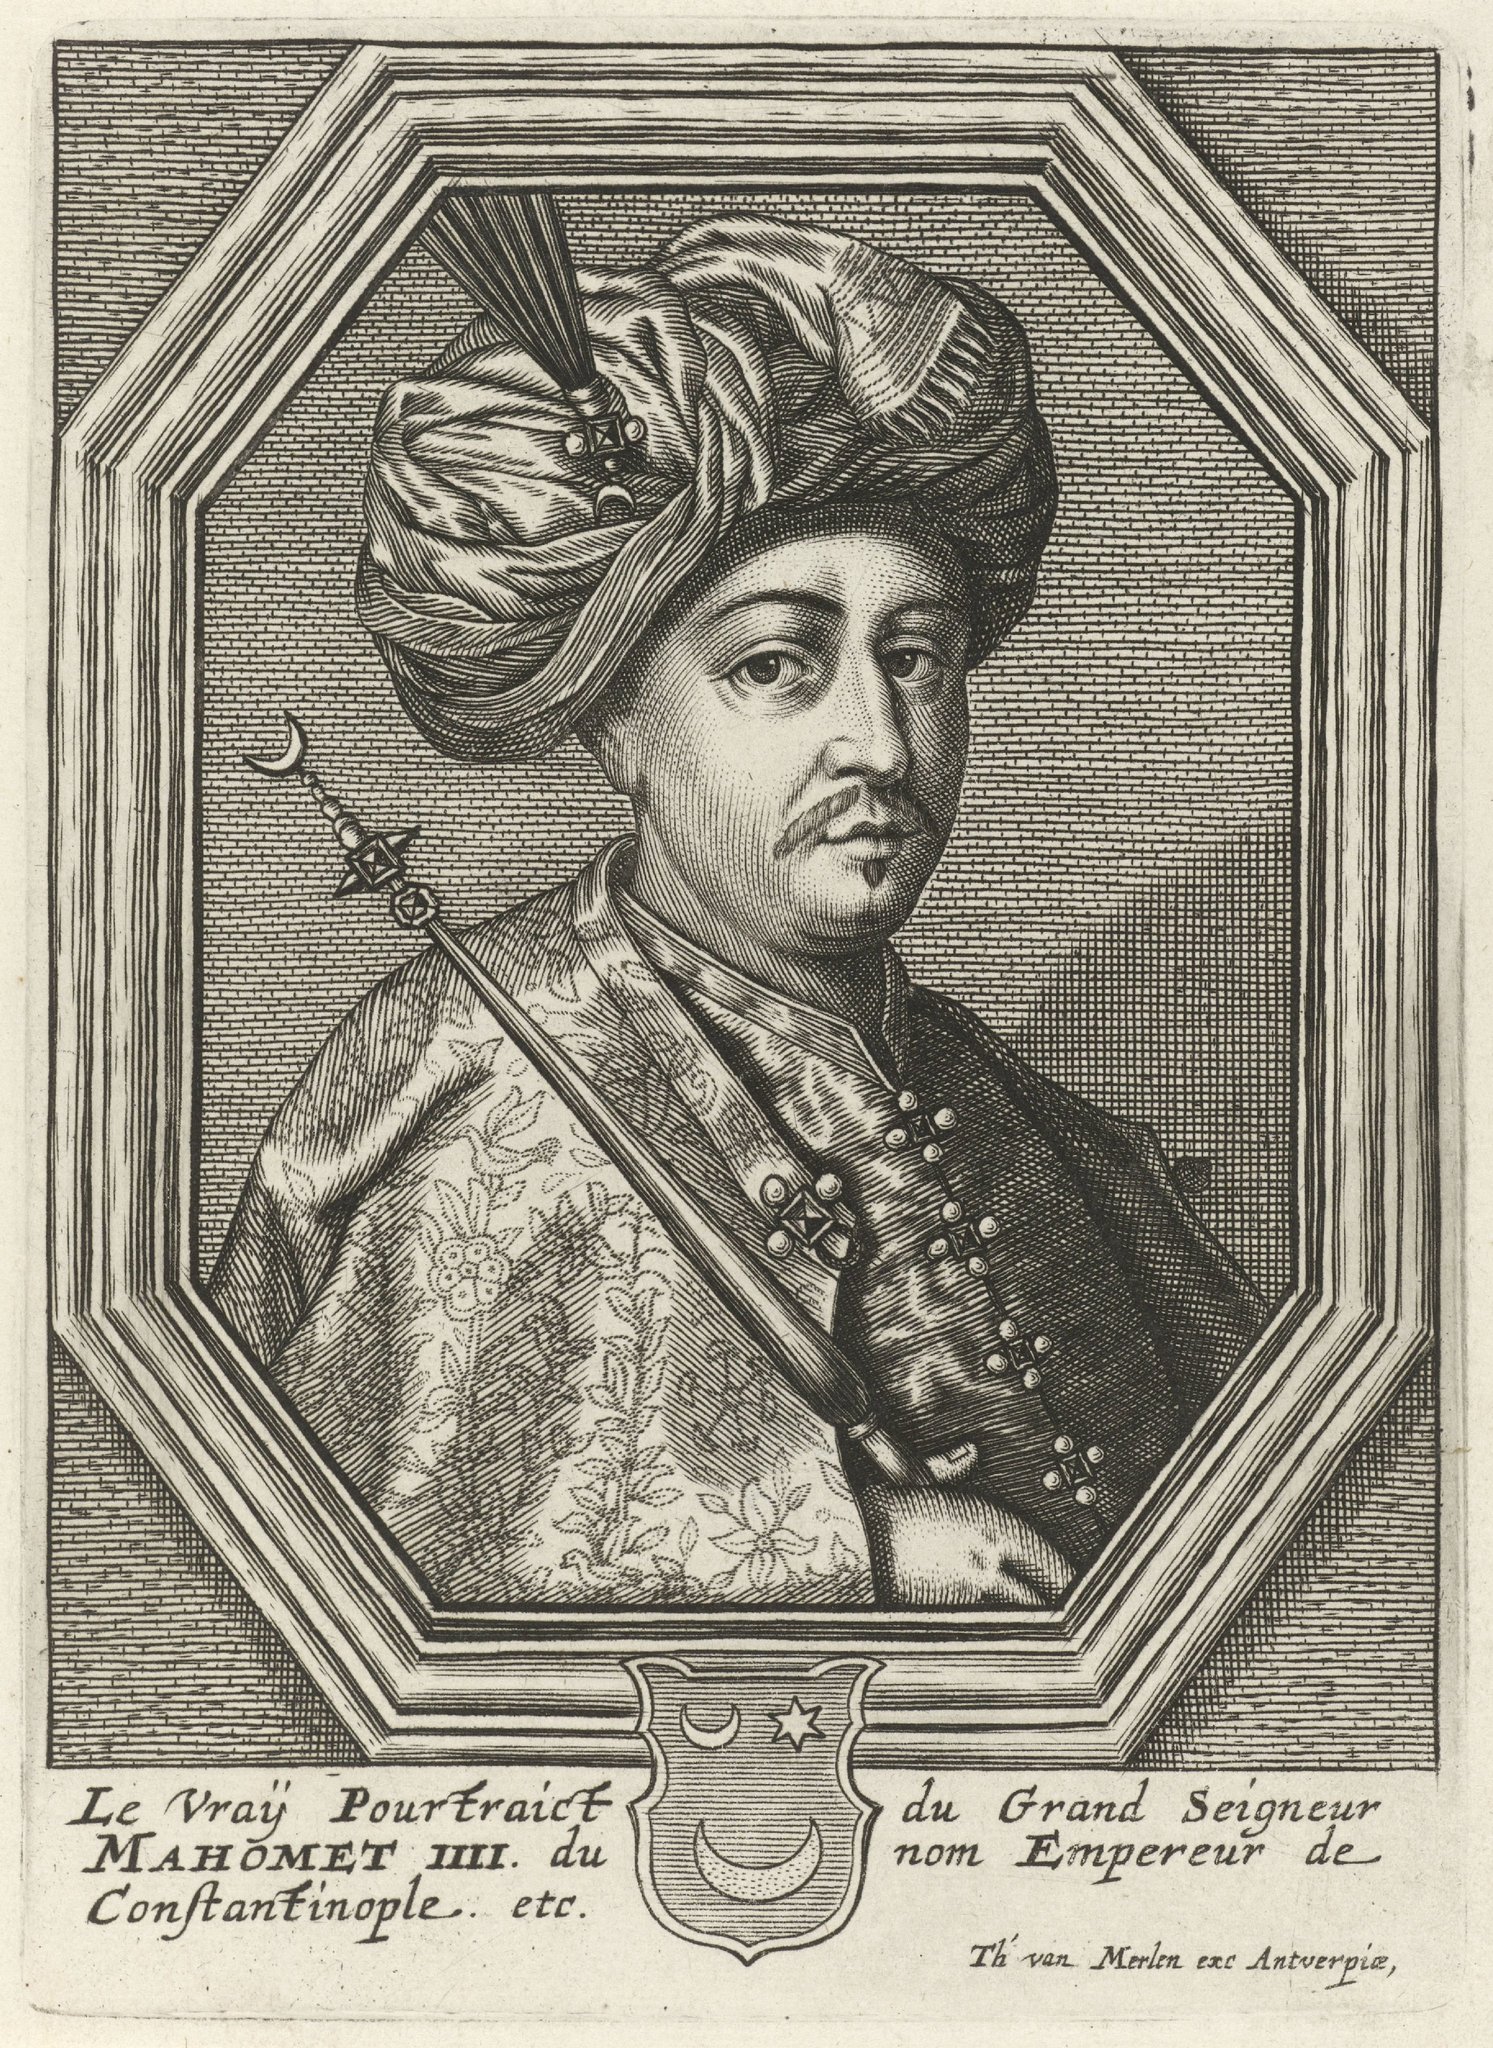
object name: print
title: Portret van sultan Mehmet IV van het Ottomaanse Rijk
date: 1619-1672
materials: paper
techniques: engraving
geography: antwerp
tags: constantinopel, sultan, mehmet iv (sultan van het ottomaanse rijk)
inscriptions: collector's mark: Lugt 2228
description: Portret van Mehmet IV, sultan van het Ottomaanse Rijk, met een scepter in zijn hand. Volgens het Franse onderschrift onderaan in de marge het echte portret.